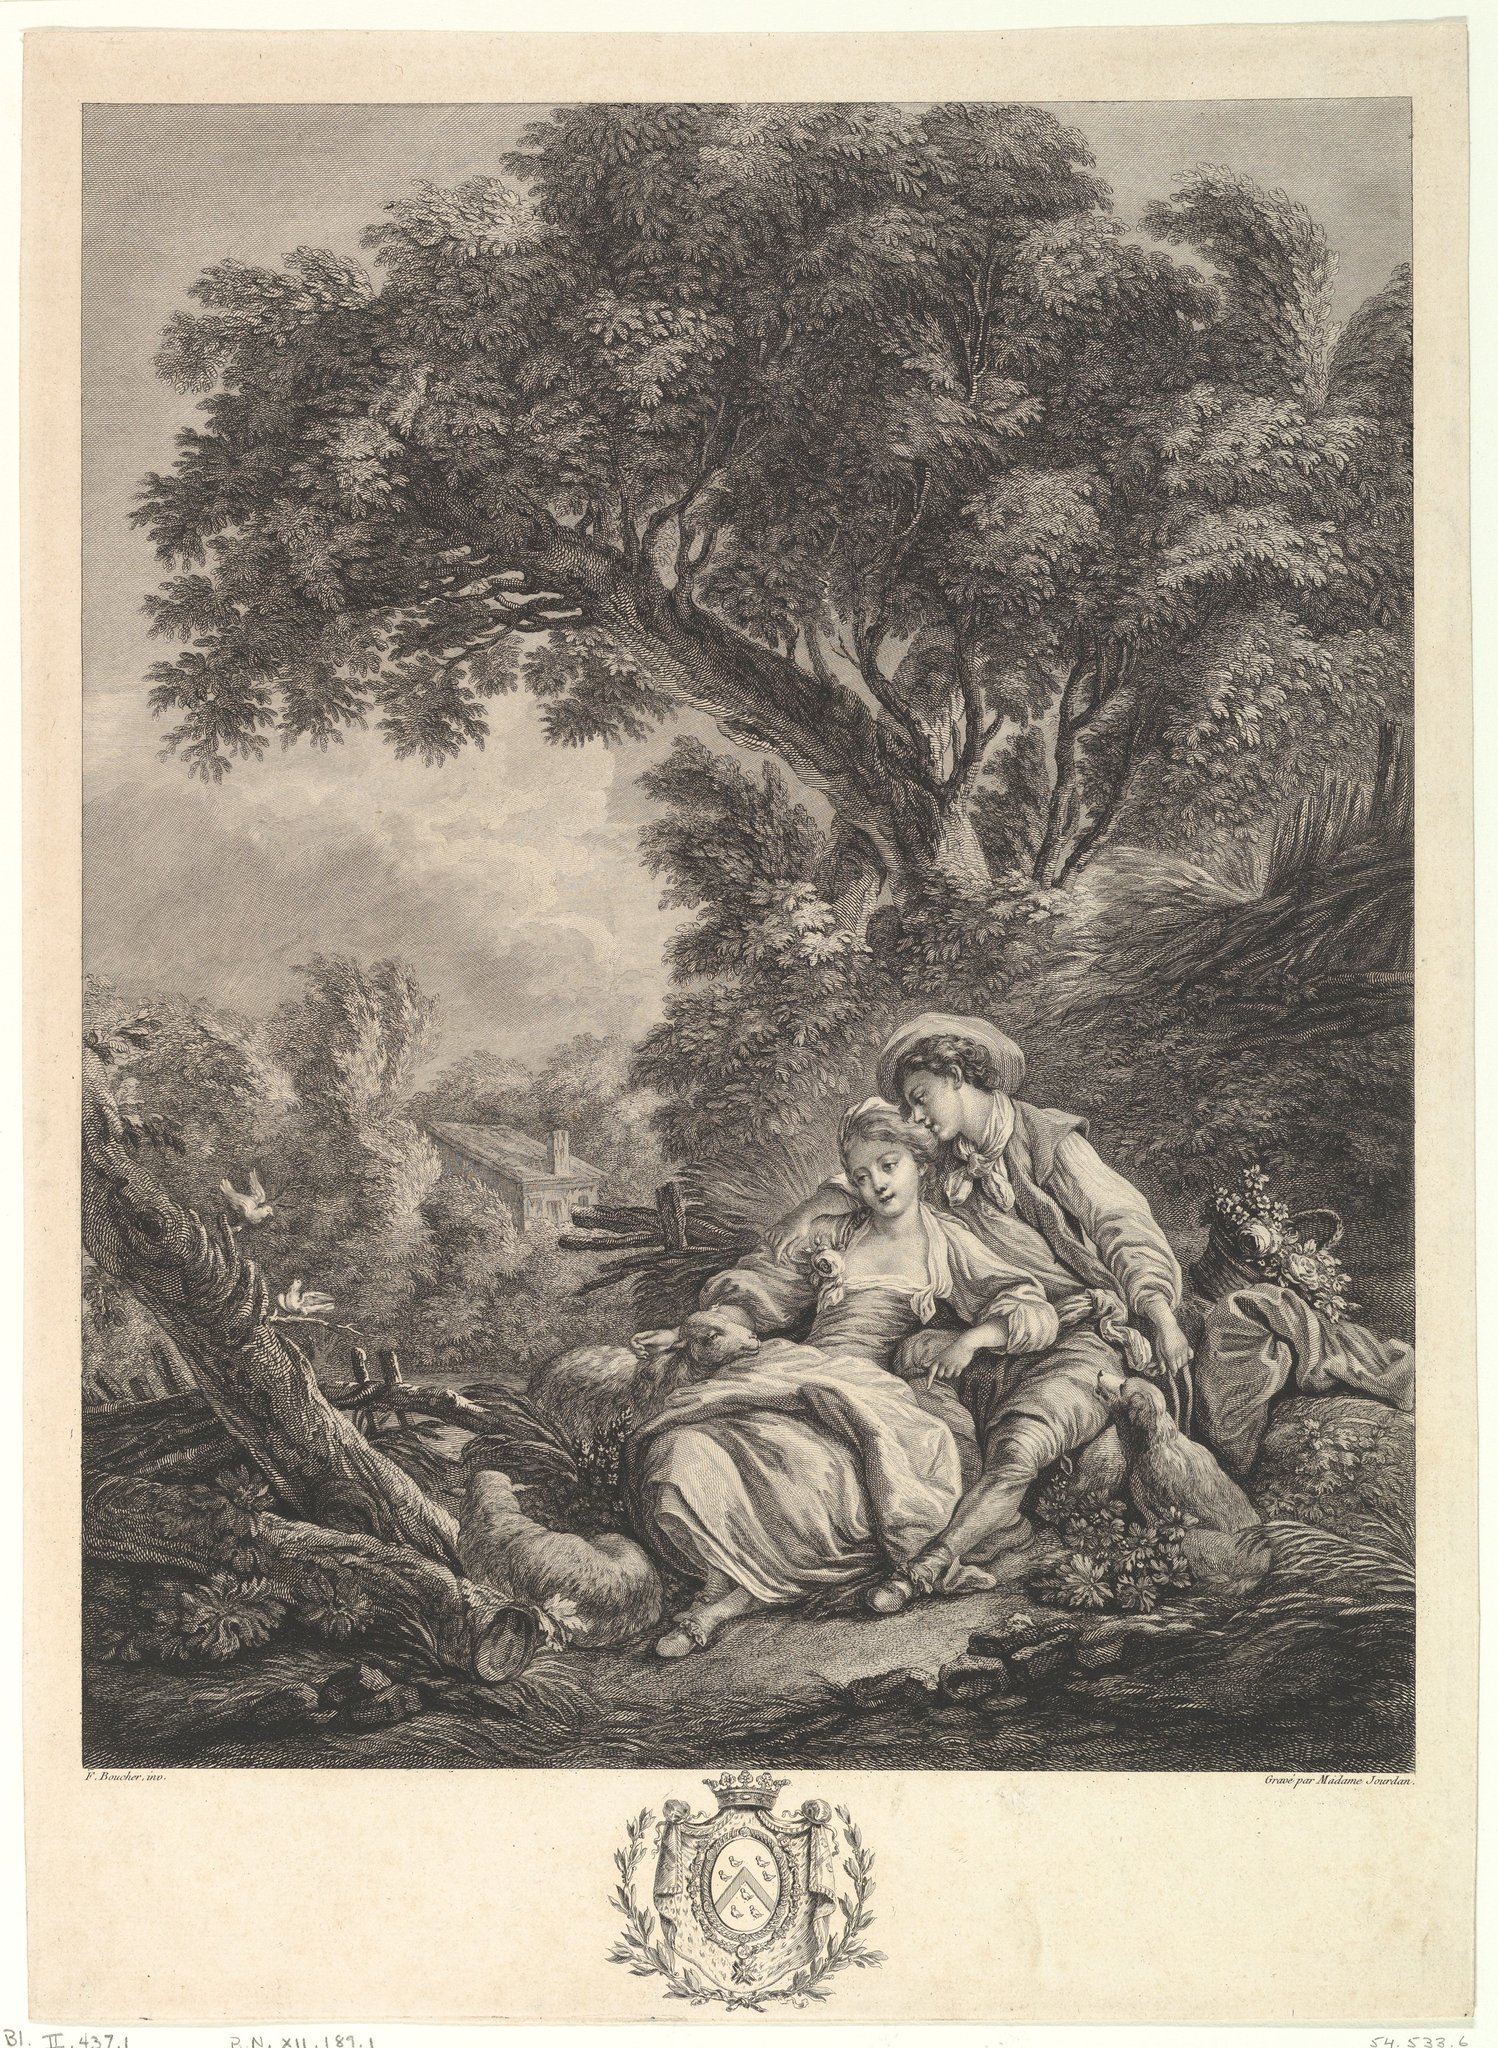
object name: print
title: Pensant-ils à ce mouton? (Are They Thinking of the Sheep)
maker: madame jourdan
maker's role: artist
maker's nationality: french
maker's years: 1780-1800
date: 1767-1800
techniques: engraving, etching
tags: boys,girls,sheep